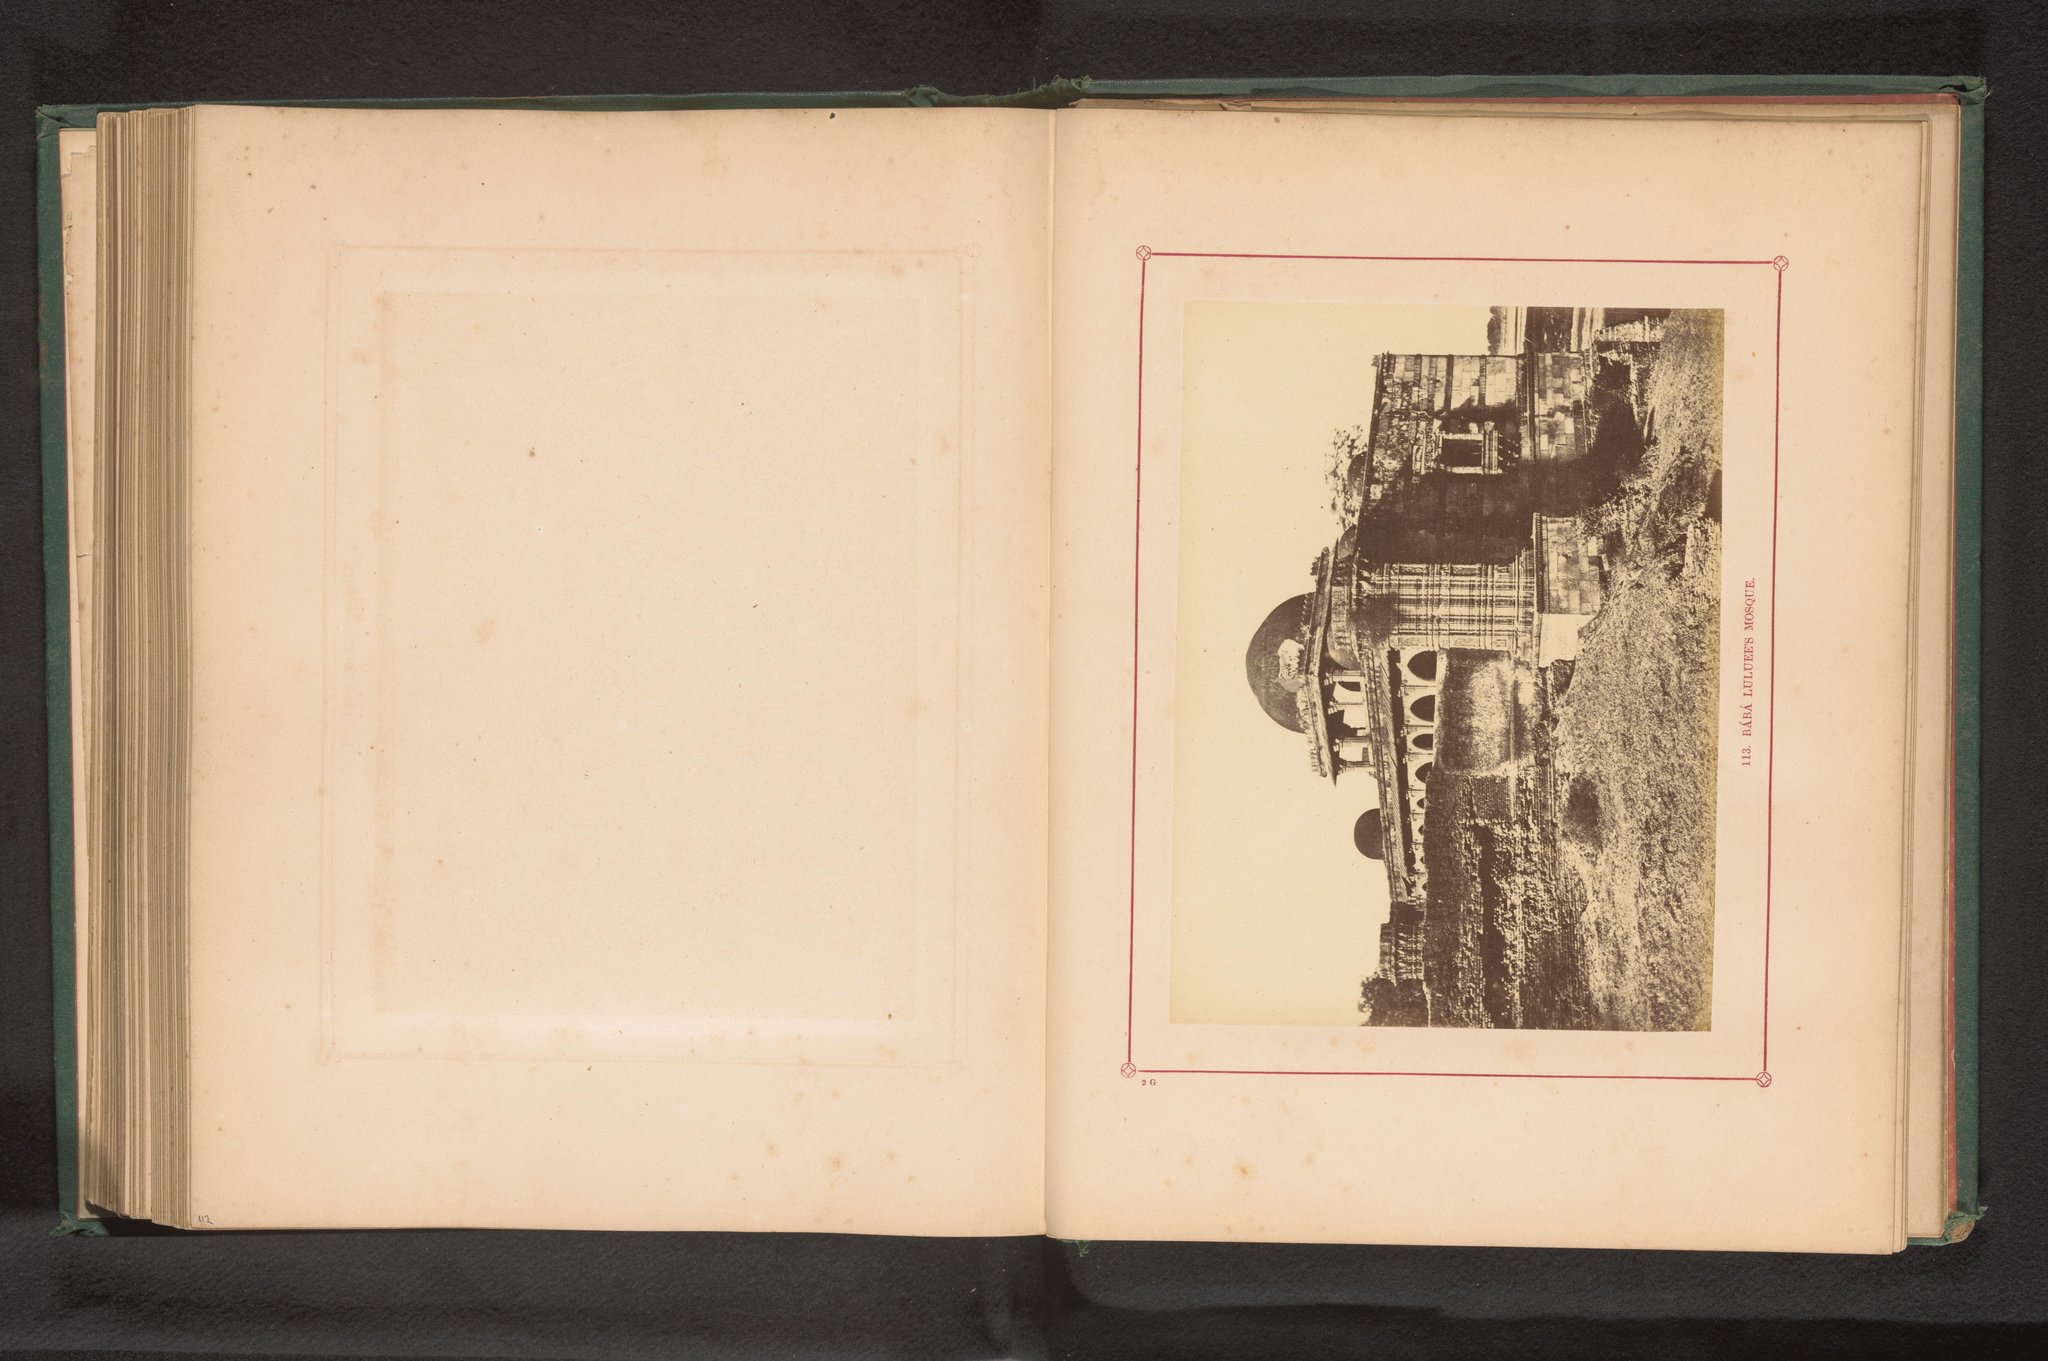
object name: page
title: Gezicht op de Baba Lului-moskee in Ahmedabad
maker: thomas biggs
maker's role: fotograaf, kapitein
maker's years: 1822-1905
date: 1856-1866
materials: photographic support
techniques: albumen print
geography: ahmedabad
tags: temple, shrine ~ islam, mohammedanism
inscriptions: inscription: ‘2G’, number: ‘113.’